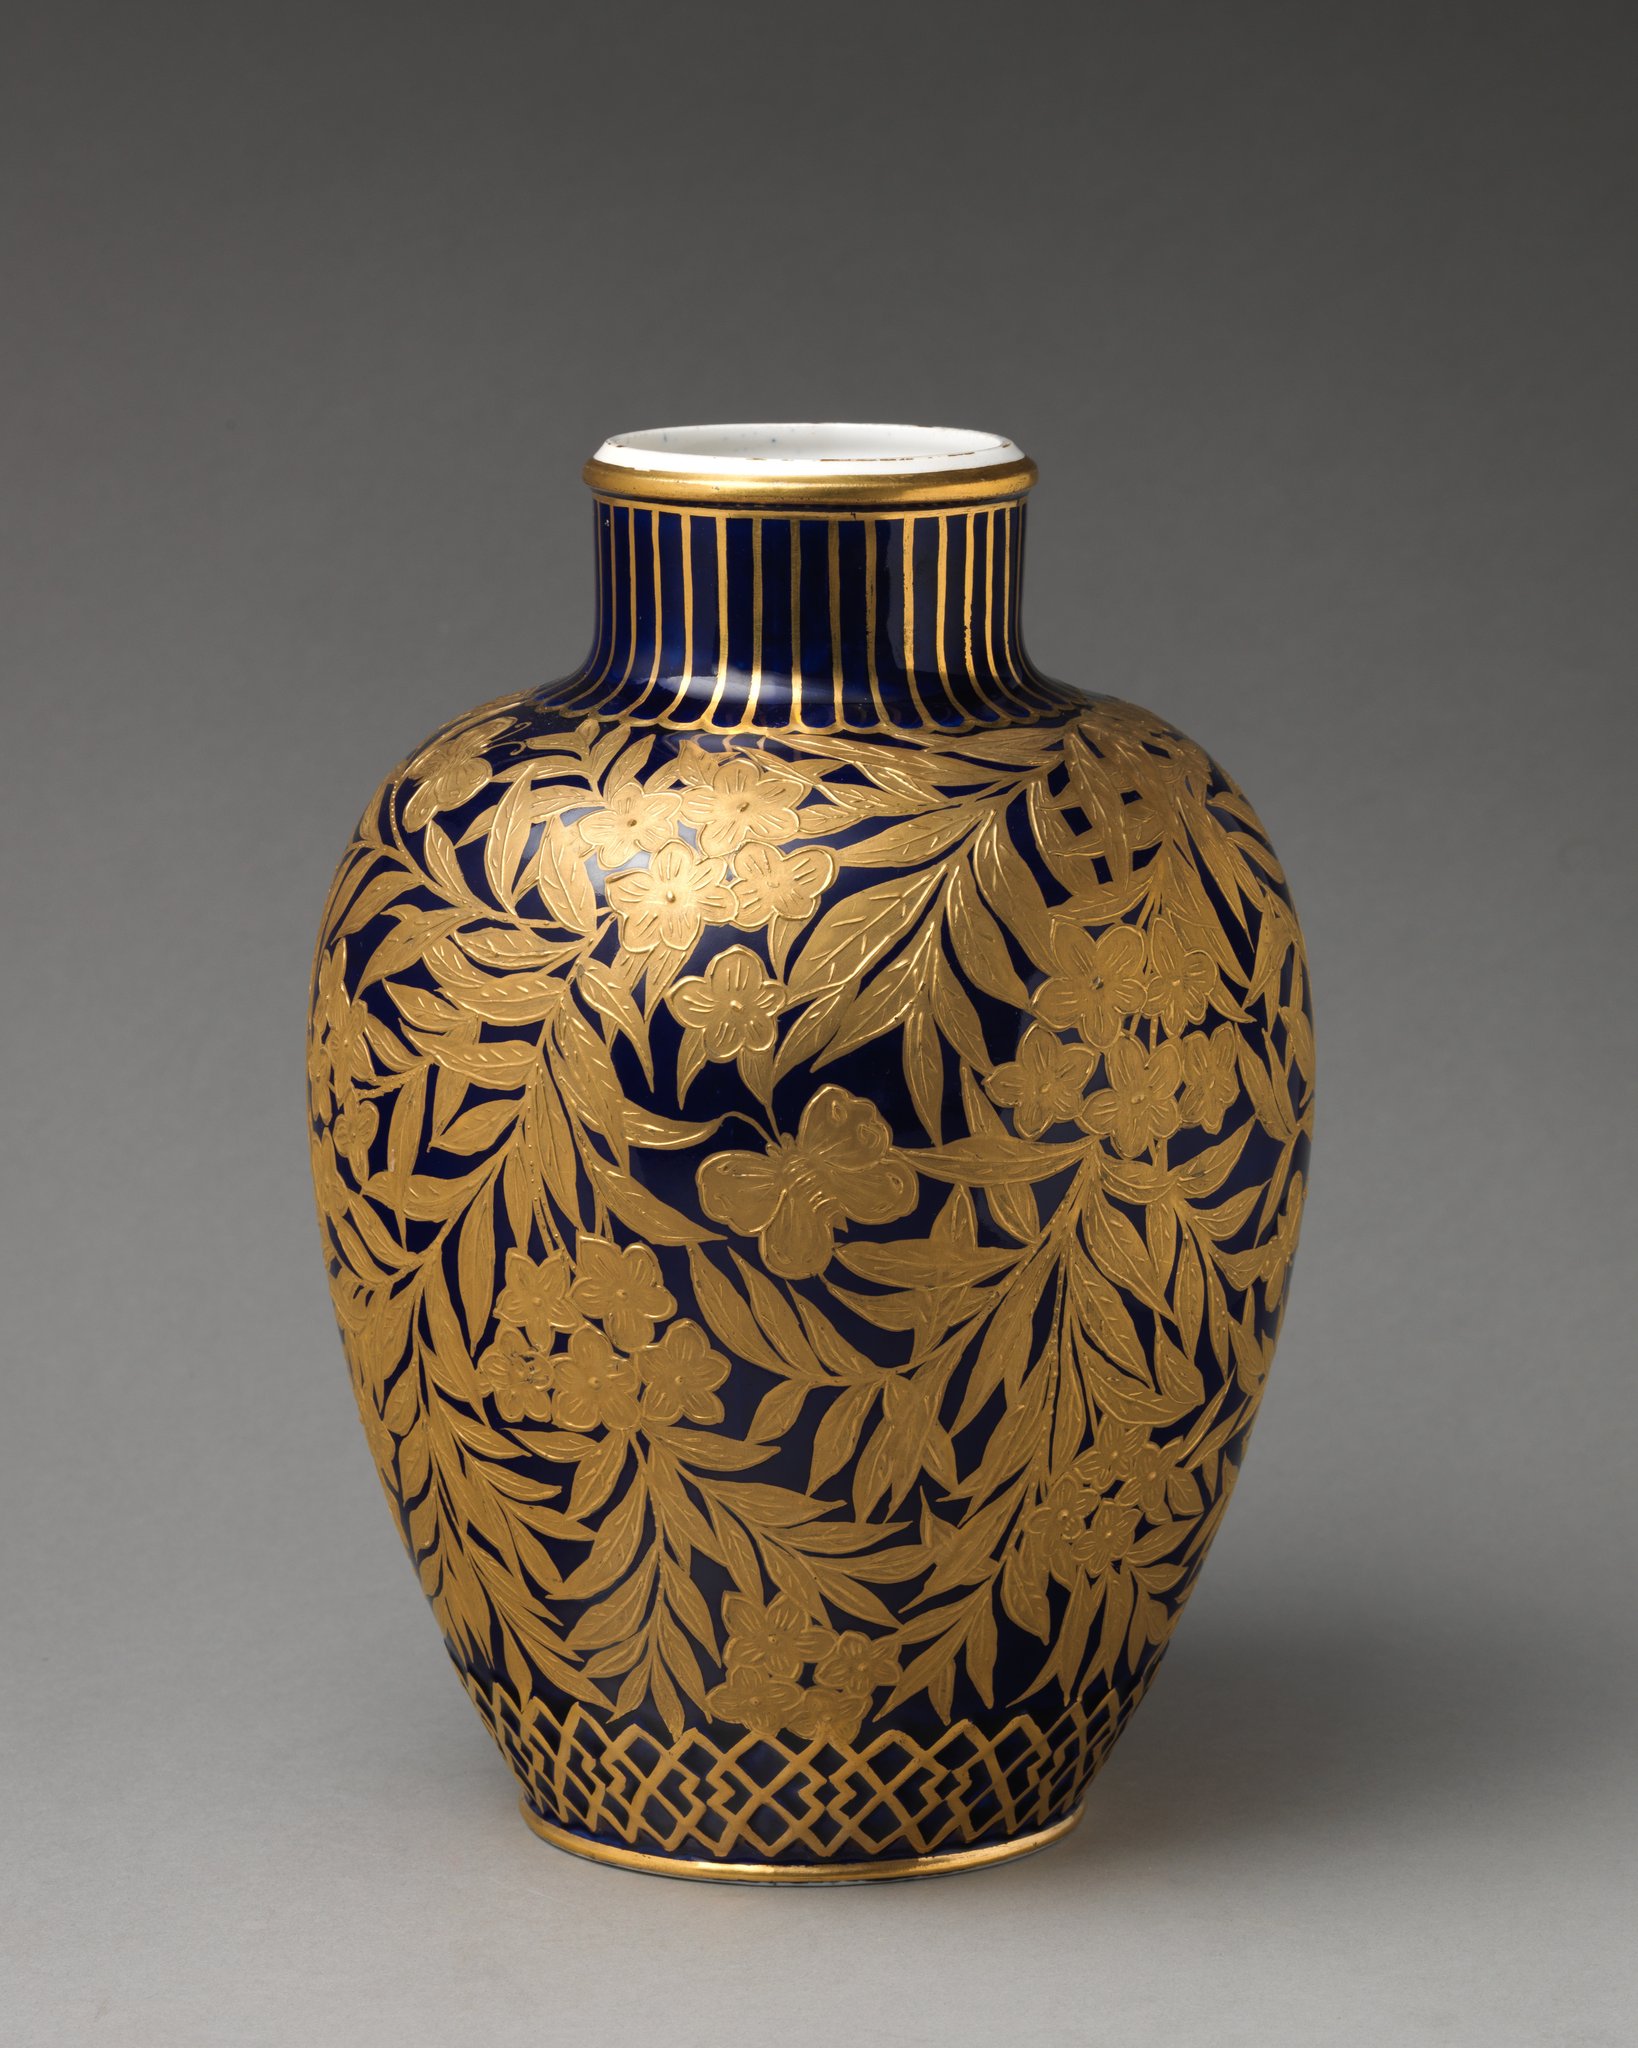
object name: vase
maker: crown derby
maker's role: maker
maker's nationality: british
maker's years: 1750-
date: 1884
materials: porcelain